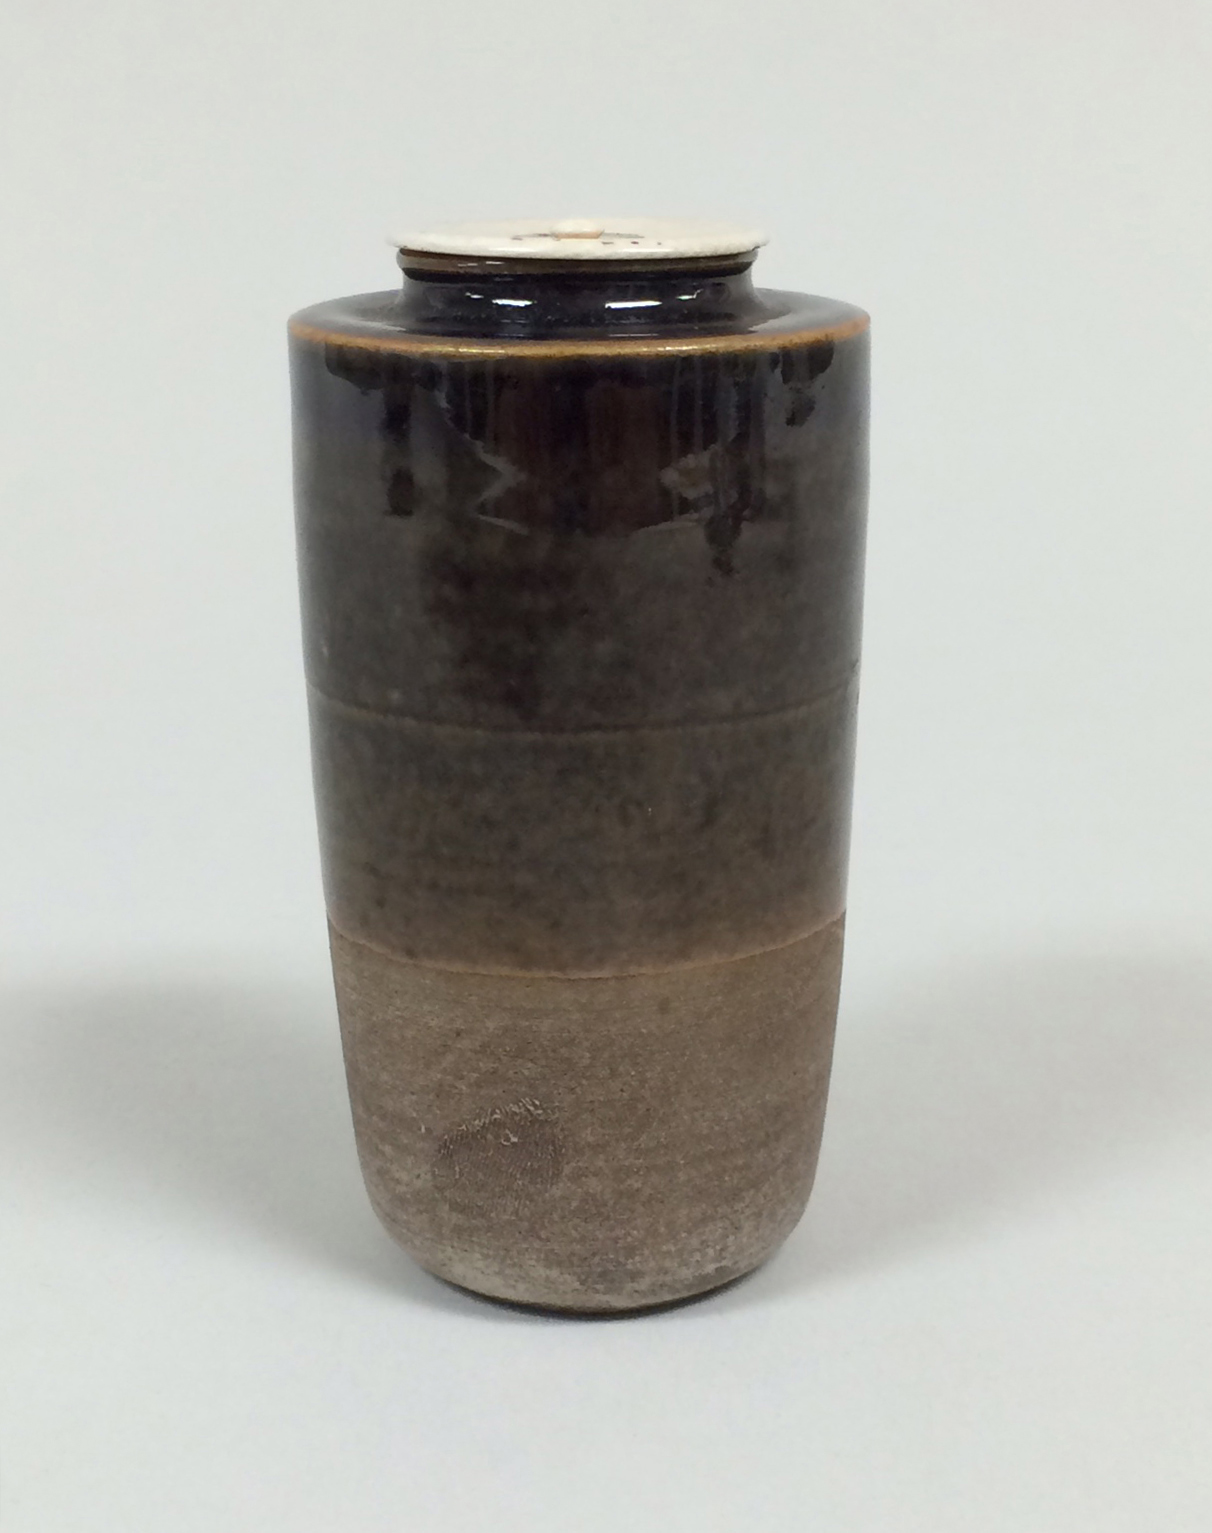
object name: tea jar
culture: japanese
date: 1701-1800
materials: clay, glaze